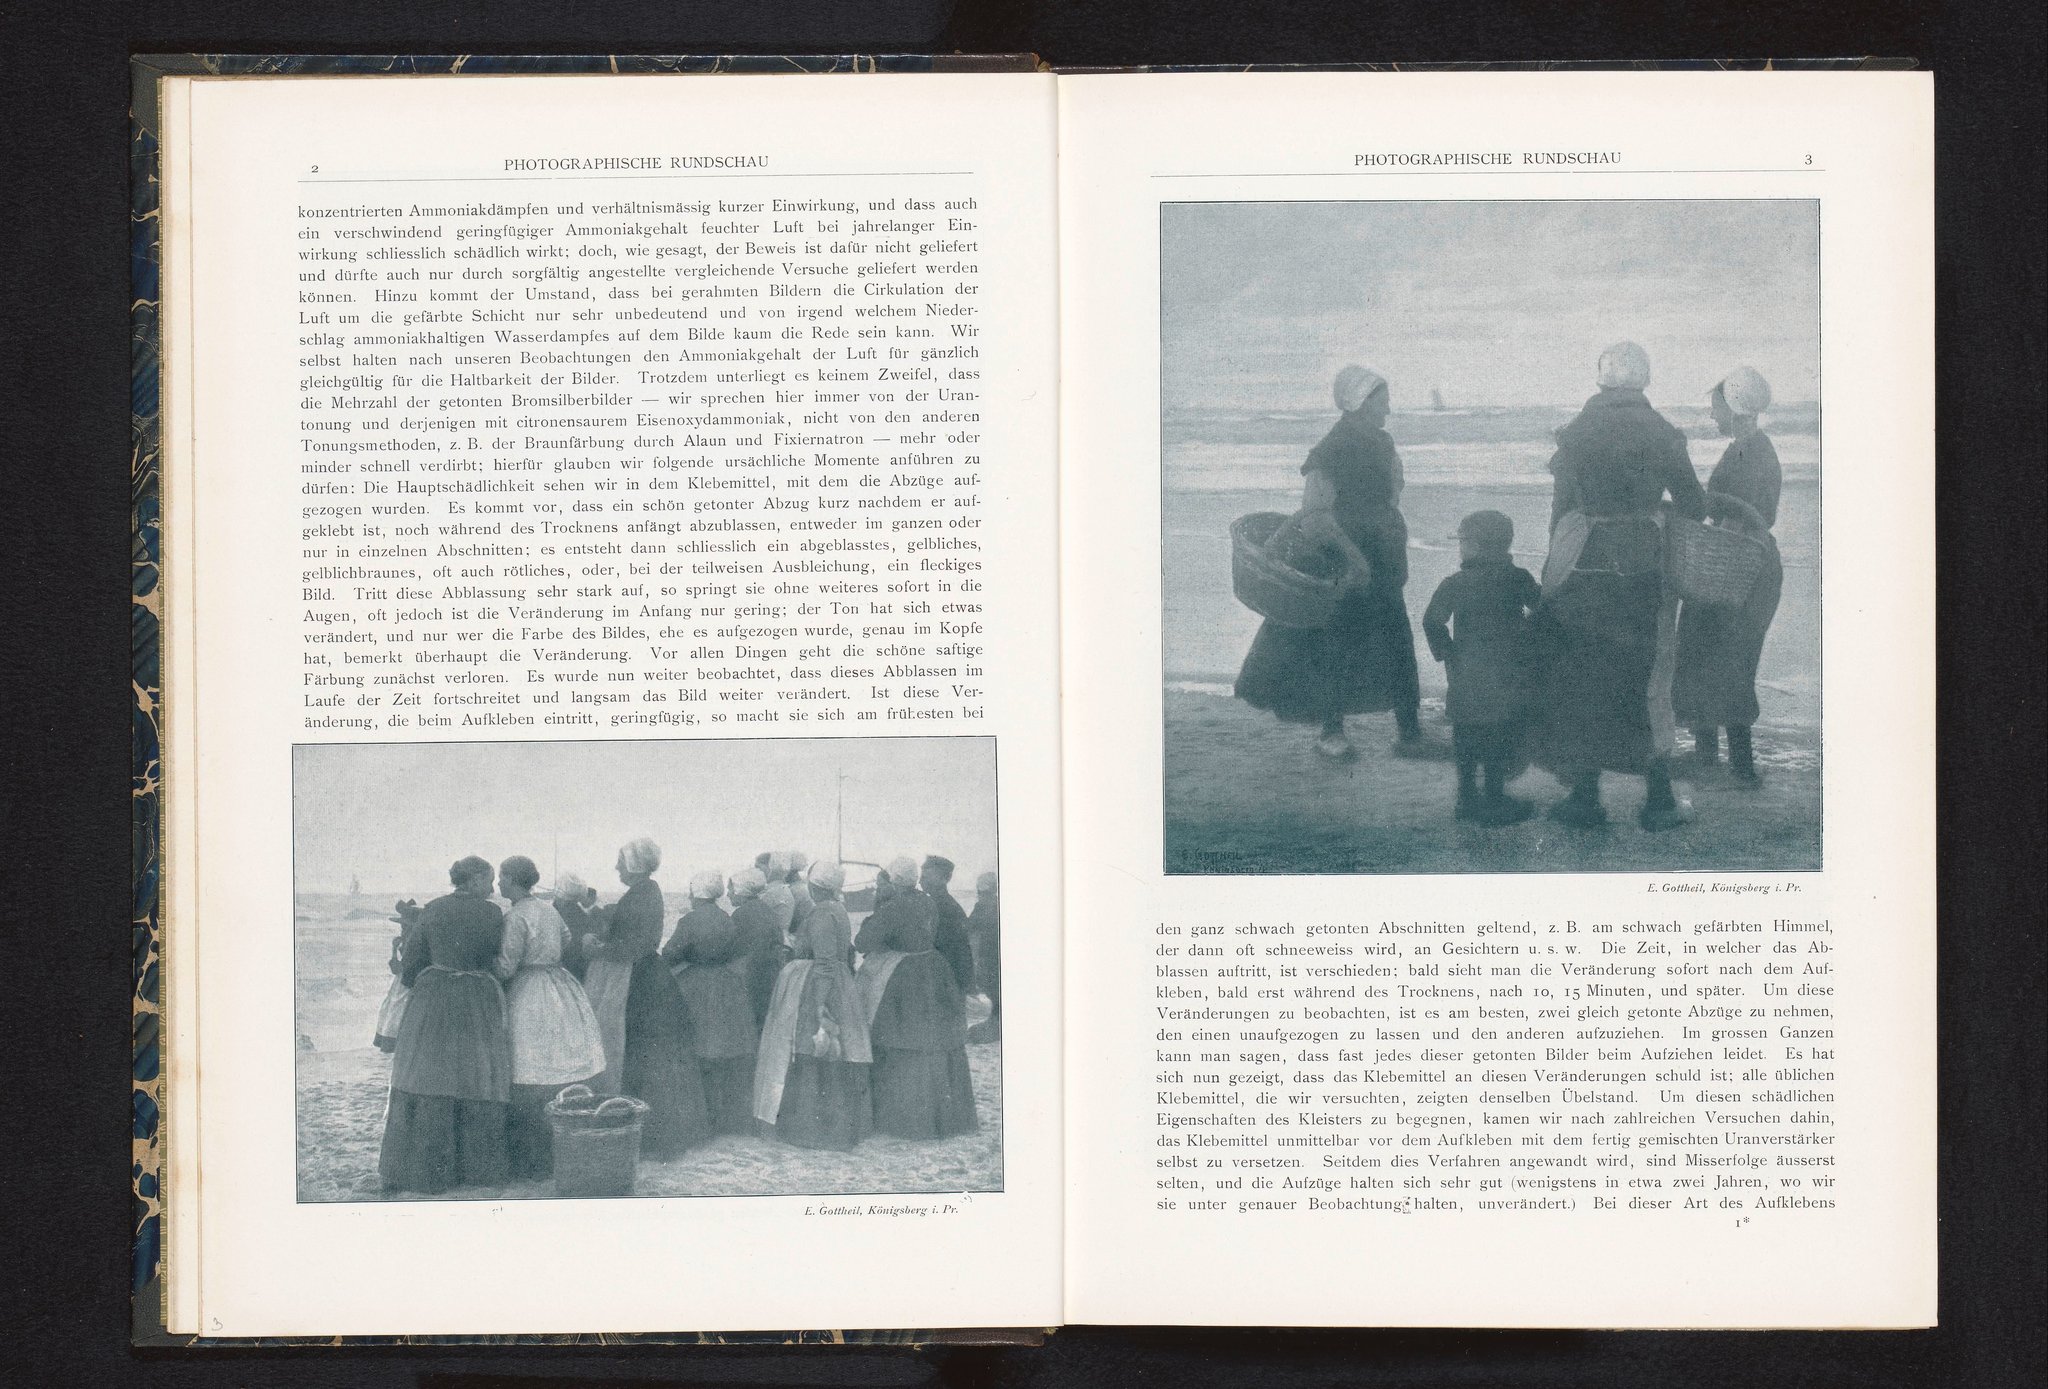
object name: page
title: Drie vrouwen en een kind aan de kust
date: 1896-1901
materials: paper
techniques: autotype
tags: adult woman, coast